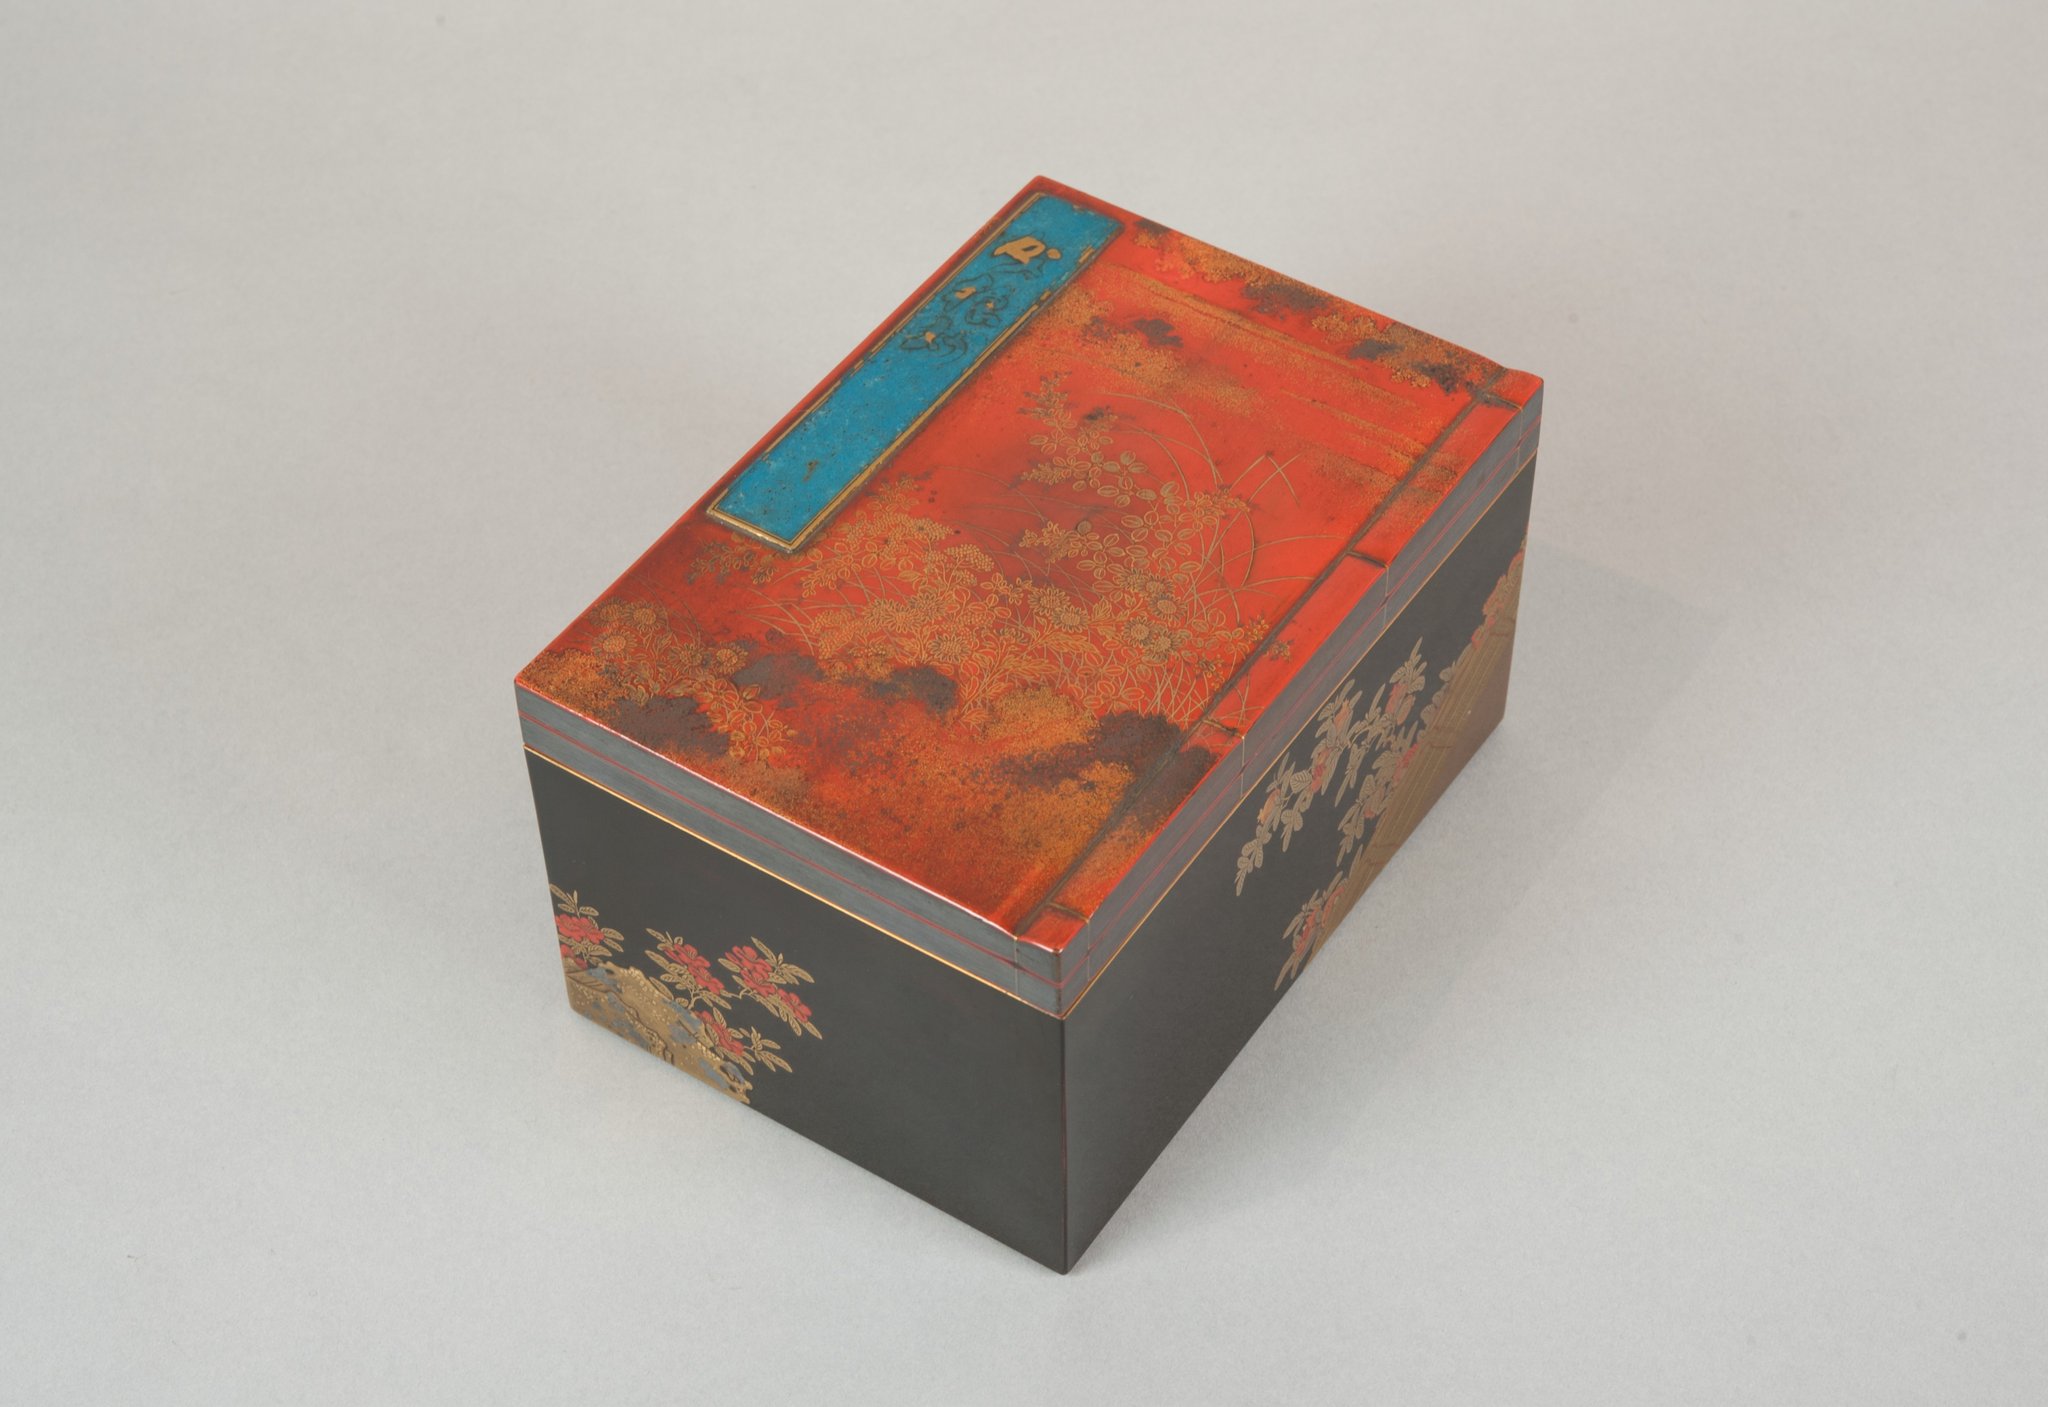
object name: box with cover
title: Incense Box with Design of Camellia, Autumn Grasses, and Tree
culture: japanese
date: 1701-1800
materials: gold, lacquer, silver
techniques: maki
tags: flowers,plants